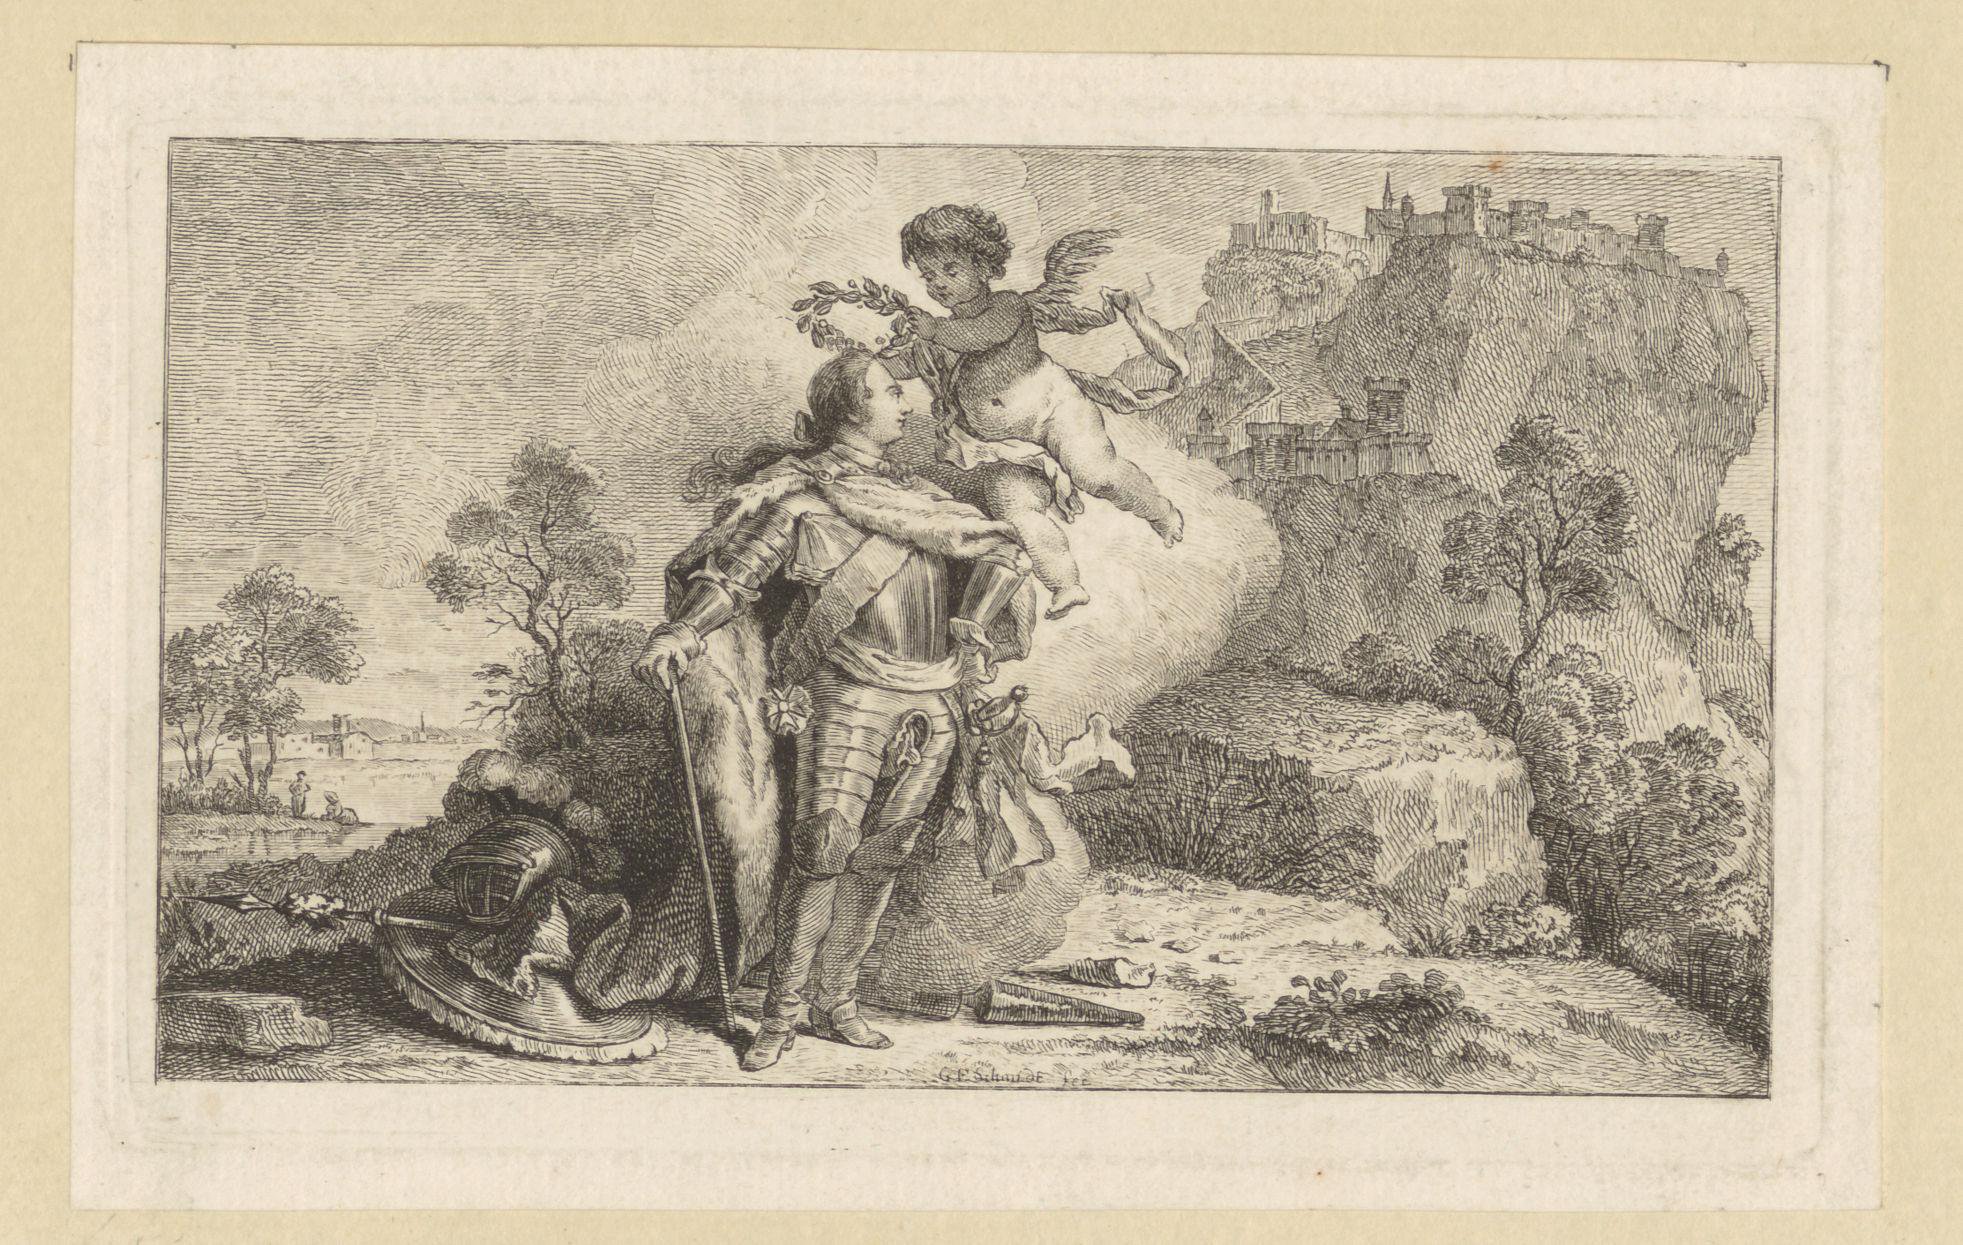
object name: book illustration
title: Held in harnas wordt door putto met lauweren gekranst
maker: georg friedrich schmidt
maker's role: draughtsman, print maker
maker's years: 1712-1775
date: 1760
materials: paper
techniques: etching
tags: men of name and fame, heroes, 'homines illustres', 'uomini famosi', crowning with laurel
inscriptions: collector's mark: Lugt 240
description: Prent ook gebruikt in: Frederik de Grote. Poësies diverses. Sanssouci, Frederik de Grote, 1760.